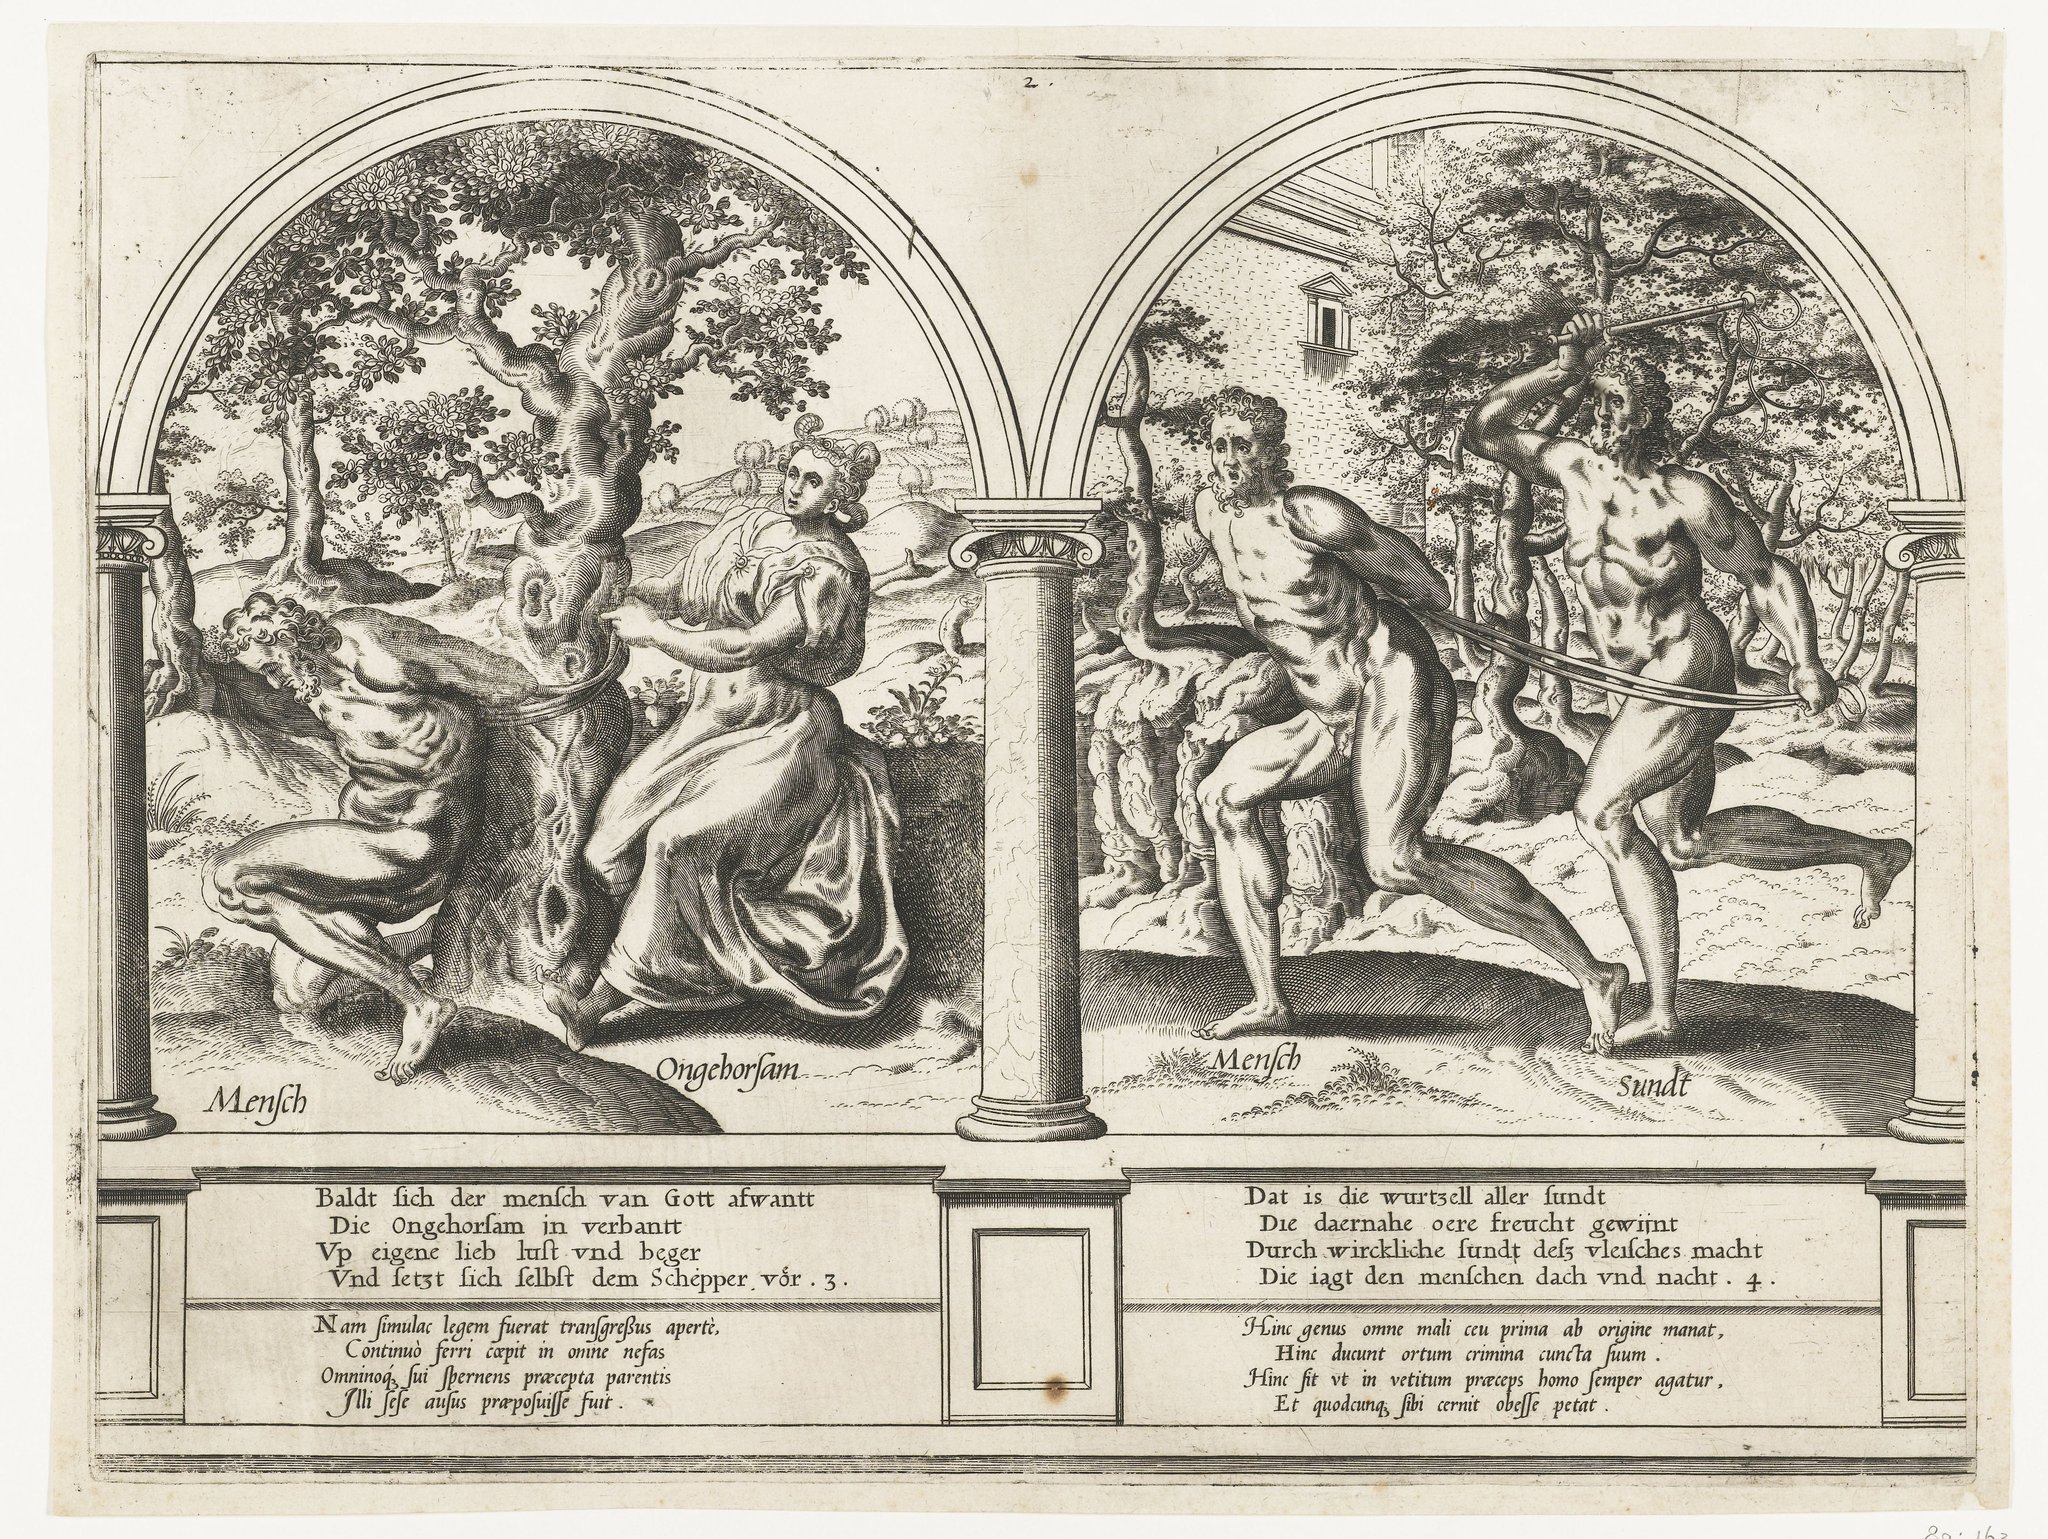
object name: print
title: De Mens door Ongehoorzaamheid gebonden en door Zonde gedreven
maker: frans huys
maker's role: print maker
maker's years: 1522-1562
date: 1546-1562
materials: paper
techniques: engraving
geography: antwerp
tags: vice, evil, sin; 'peccato' (ripa), human being, man in general, doctrine on original sin, and redemption, disobedience, contumacy, insubordination; 'inubidienza' (ripa) (+ personification)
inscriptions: collector's mark: Lugt 2228, collector's mark: Lugt 2760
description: Twee bijbelse allegorieën in architecturale omlijsting. Links wordt de afvallige Mens, die zich laat leiden door eigenliefde, lust, begeerte en hovaardij, door de personificatie van de Ongehoorzaamheid aan een boom gebonden. Rechts wordt de gebonden Mens door de personificatie van de Zonde opgejaagd met een gesel. Onder beide voorstellingen een vierregelig vers in het Nederduits en een vierregelige tekst in het Latijn. Nummer 3 en 4 uit een reformatorische serie over de zondigheid en rechtvaardiging van de mens.